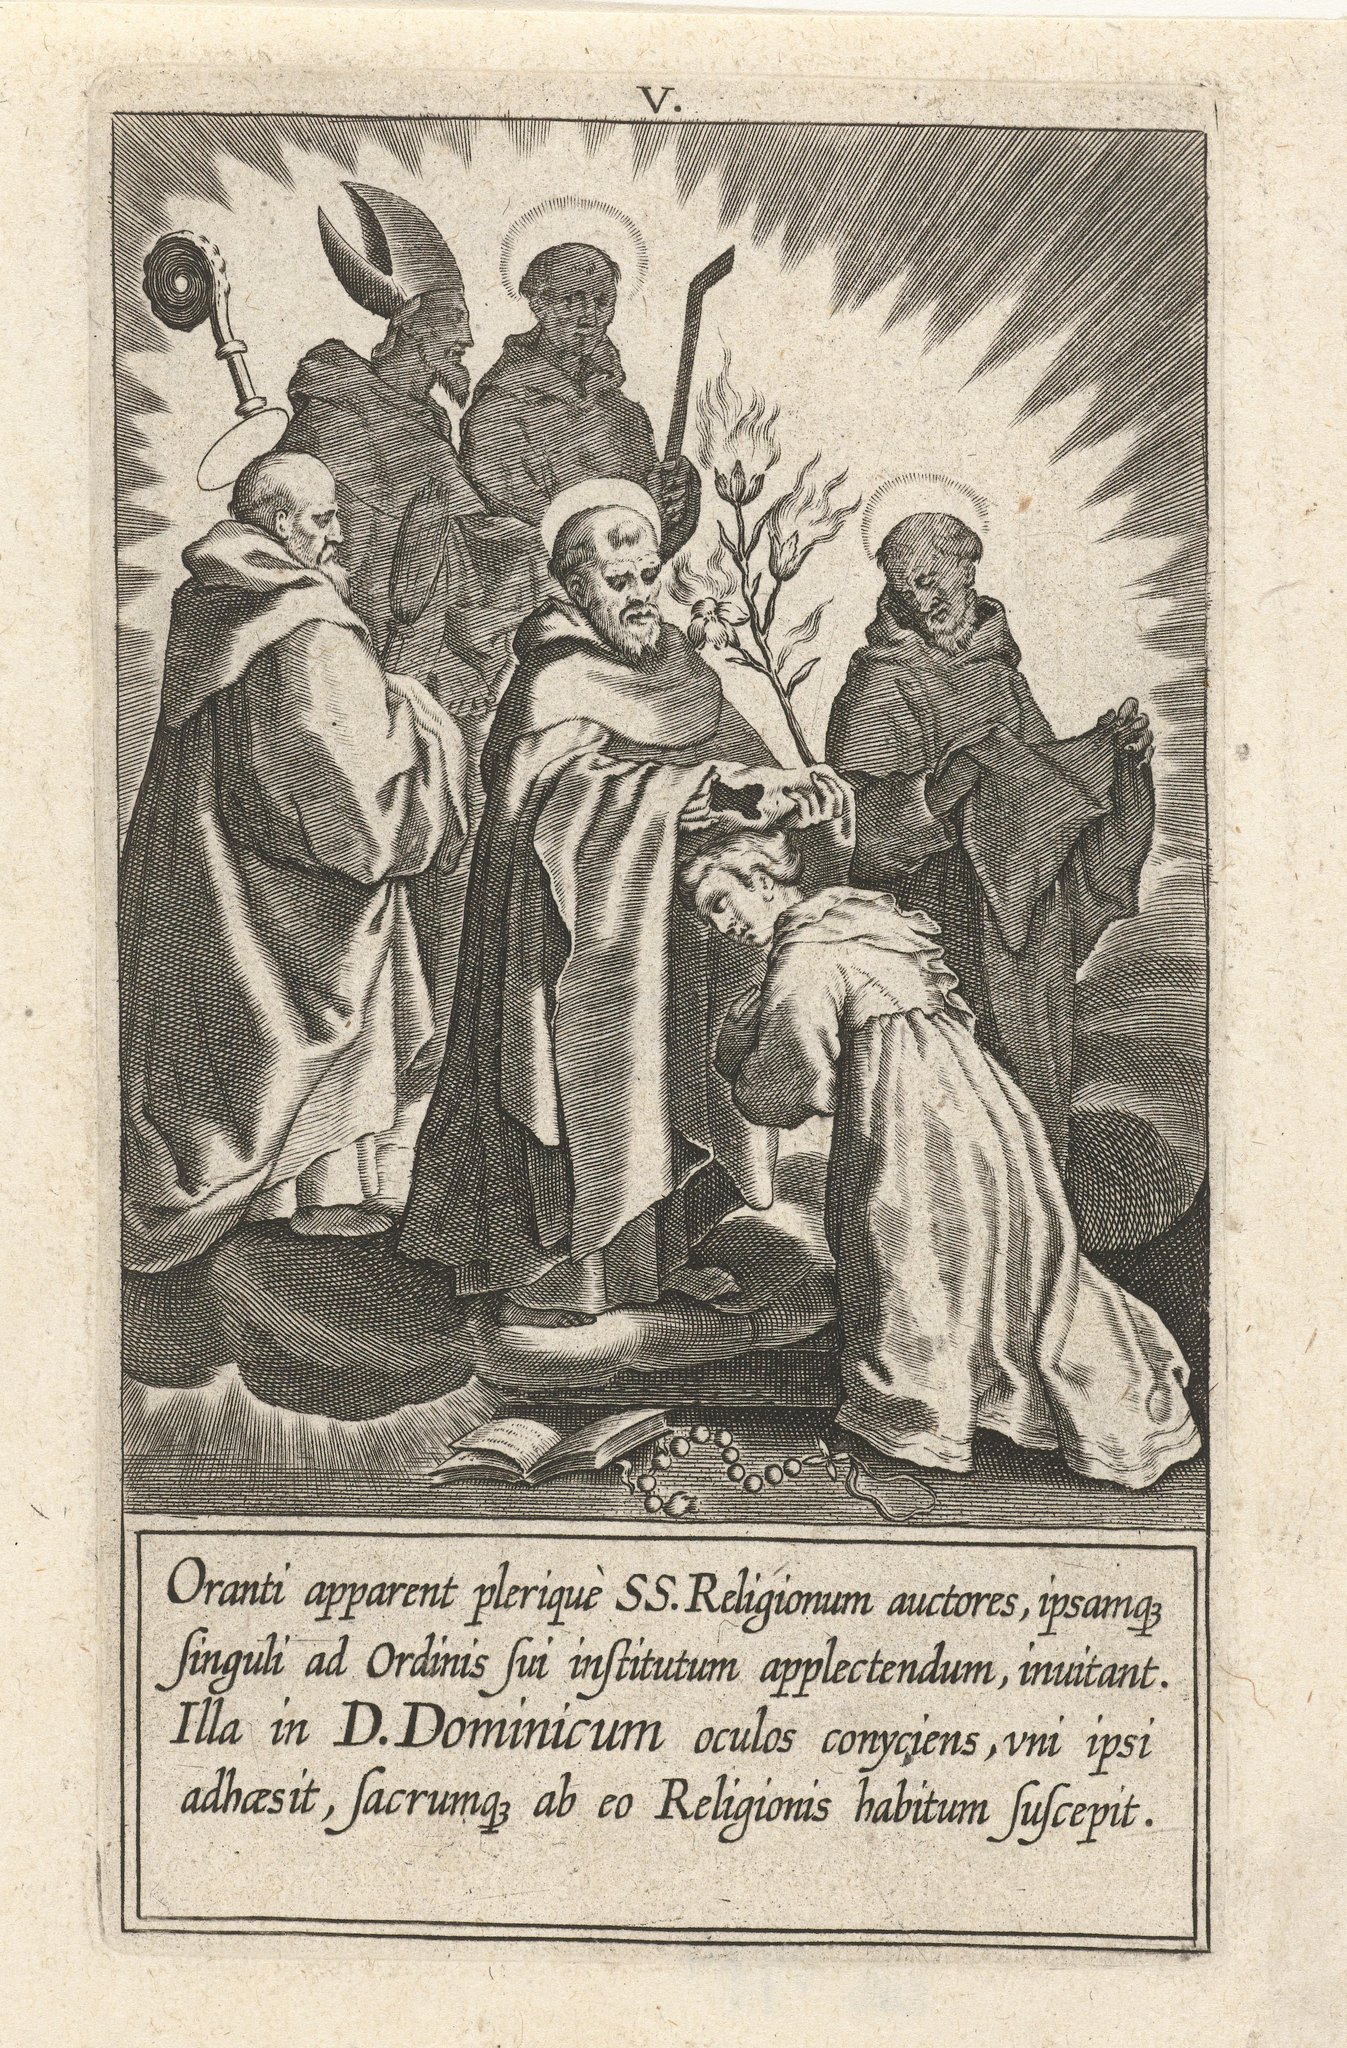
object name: print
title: Catharina wordt dominicanes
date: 1603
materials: paper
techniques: engraving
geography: antwerp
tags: the virgin and dominican tertiary, catherine of siena; possible attributes: book, cross, crown of thorns, crucifix, demon under foot, heart (with cross), lily, plague-stricken, ring, rosary, stigmata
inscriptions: collector's mark: Lugt 2228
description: Catharina knielt voor een Dominicaan die haar de sluier omlegt. Achter de man staan vier bekende Dominicaanse auteurs. Deel van een serie over Catharina van Siena bestaande uit een titelprent, een portret en 32 genummerde scènes uit haar leven.